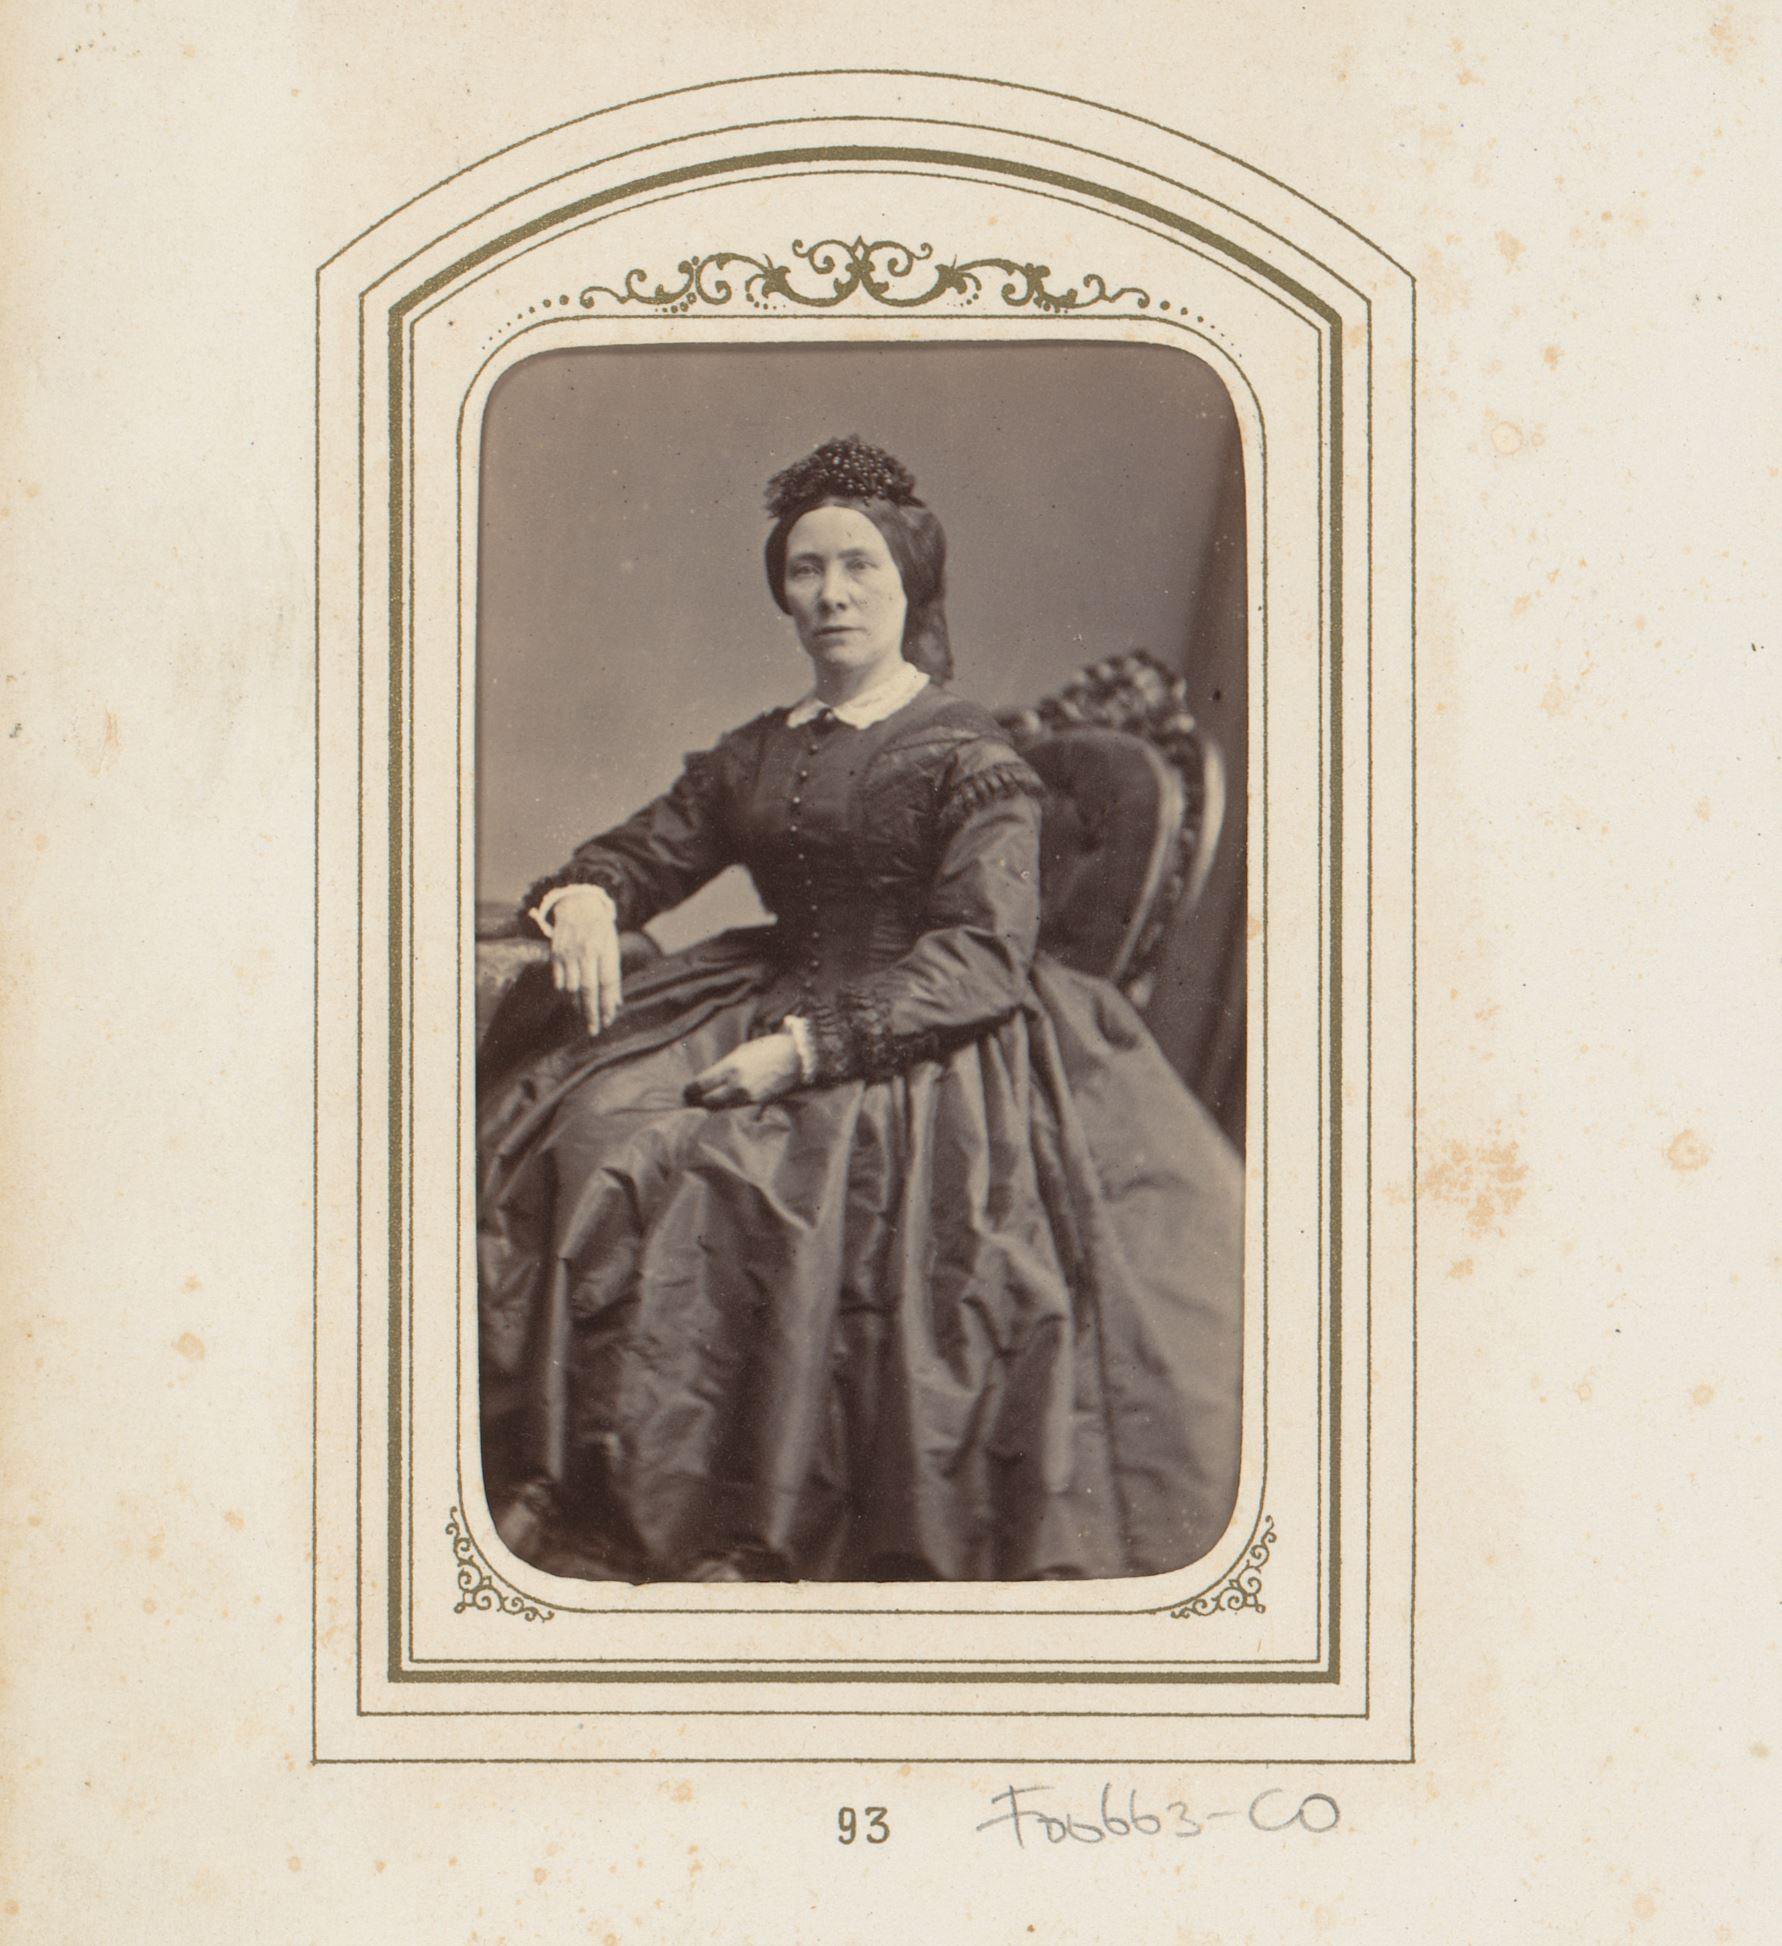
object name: album leaf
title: Portret van een zittende vrouw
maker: Anonymous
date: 1860-1880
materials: cardboard, photographic support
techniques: albumen print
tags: historical persons - bb - woman, head-gear: cap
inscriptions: number: ‘93’